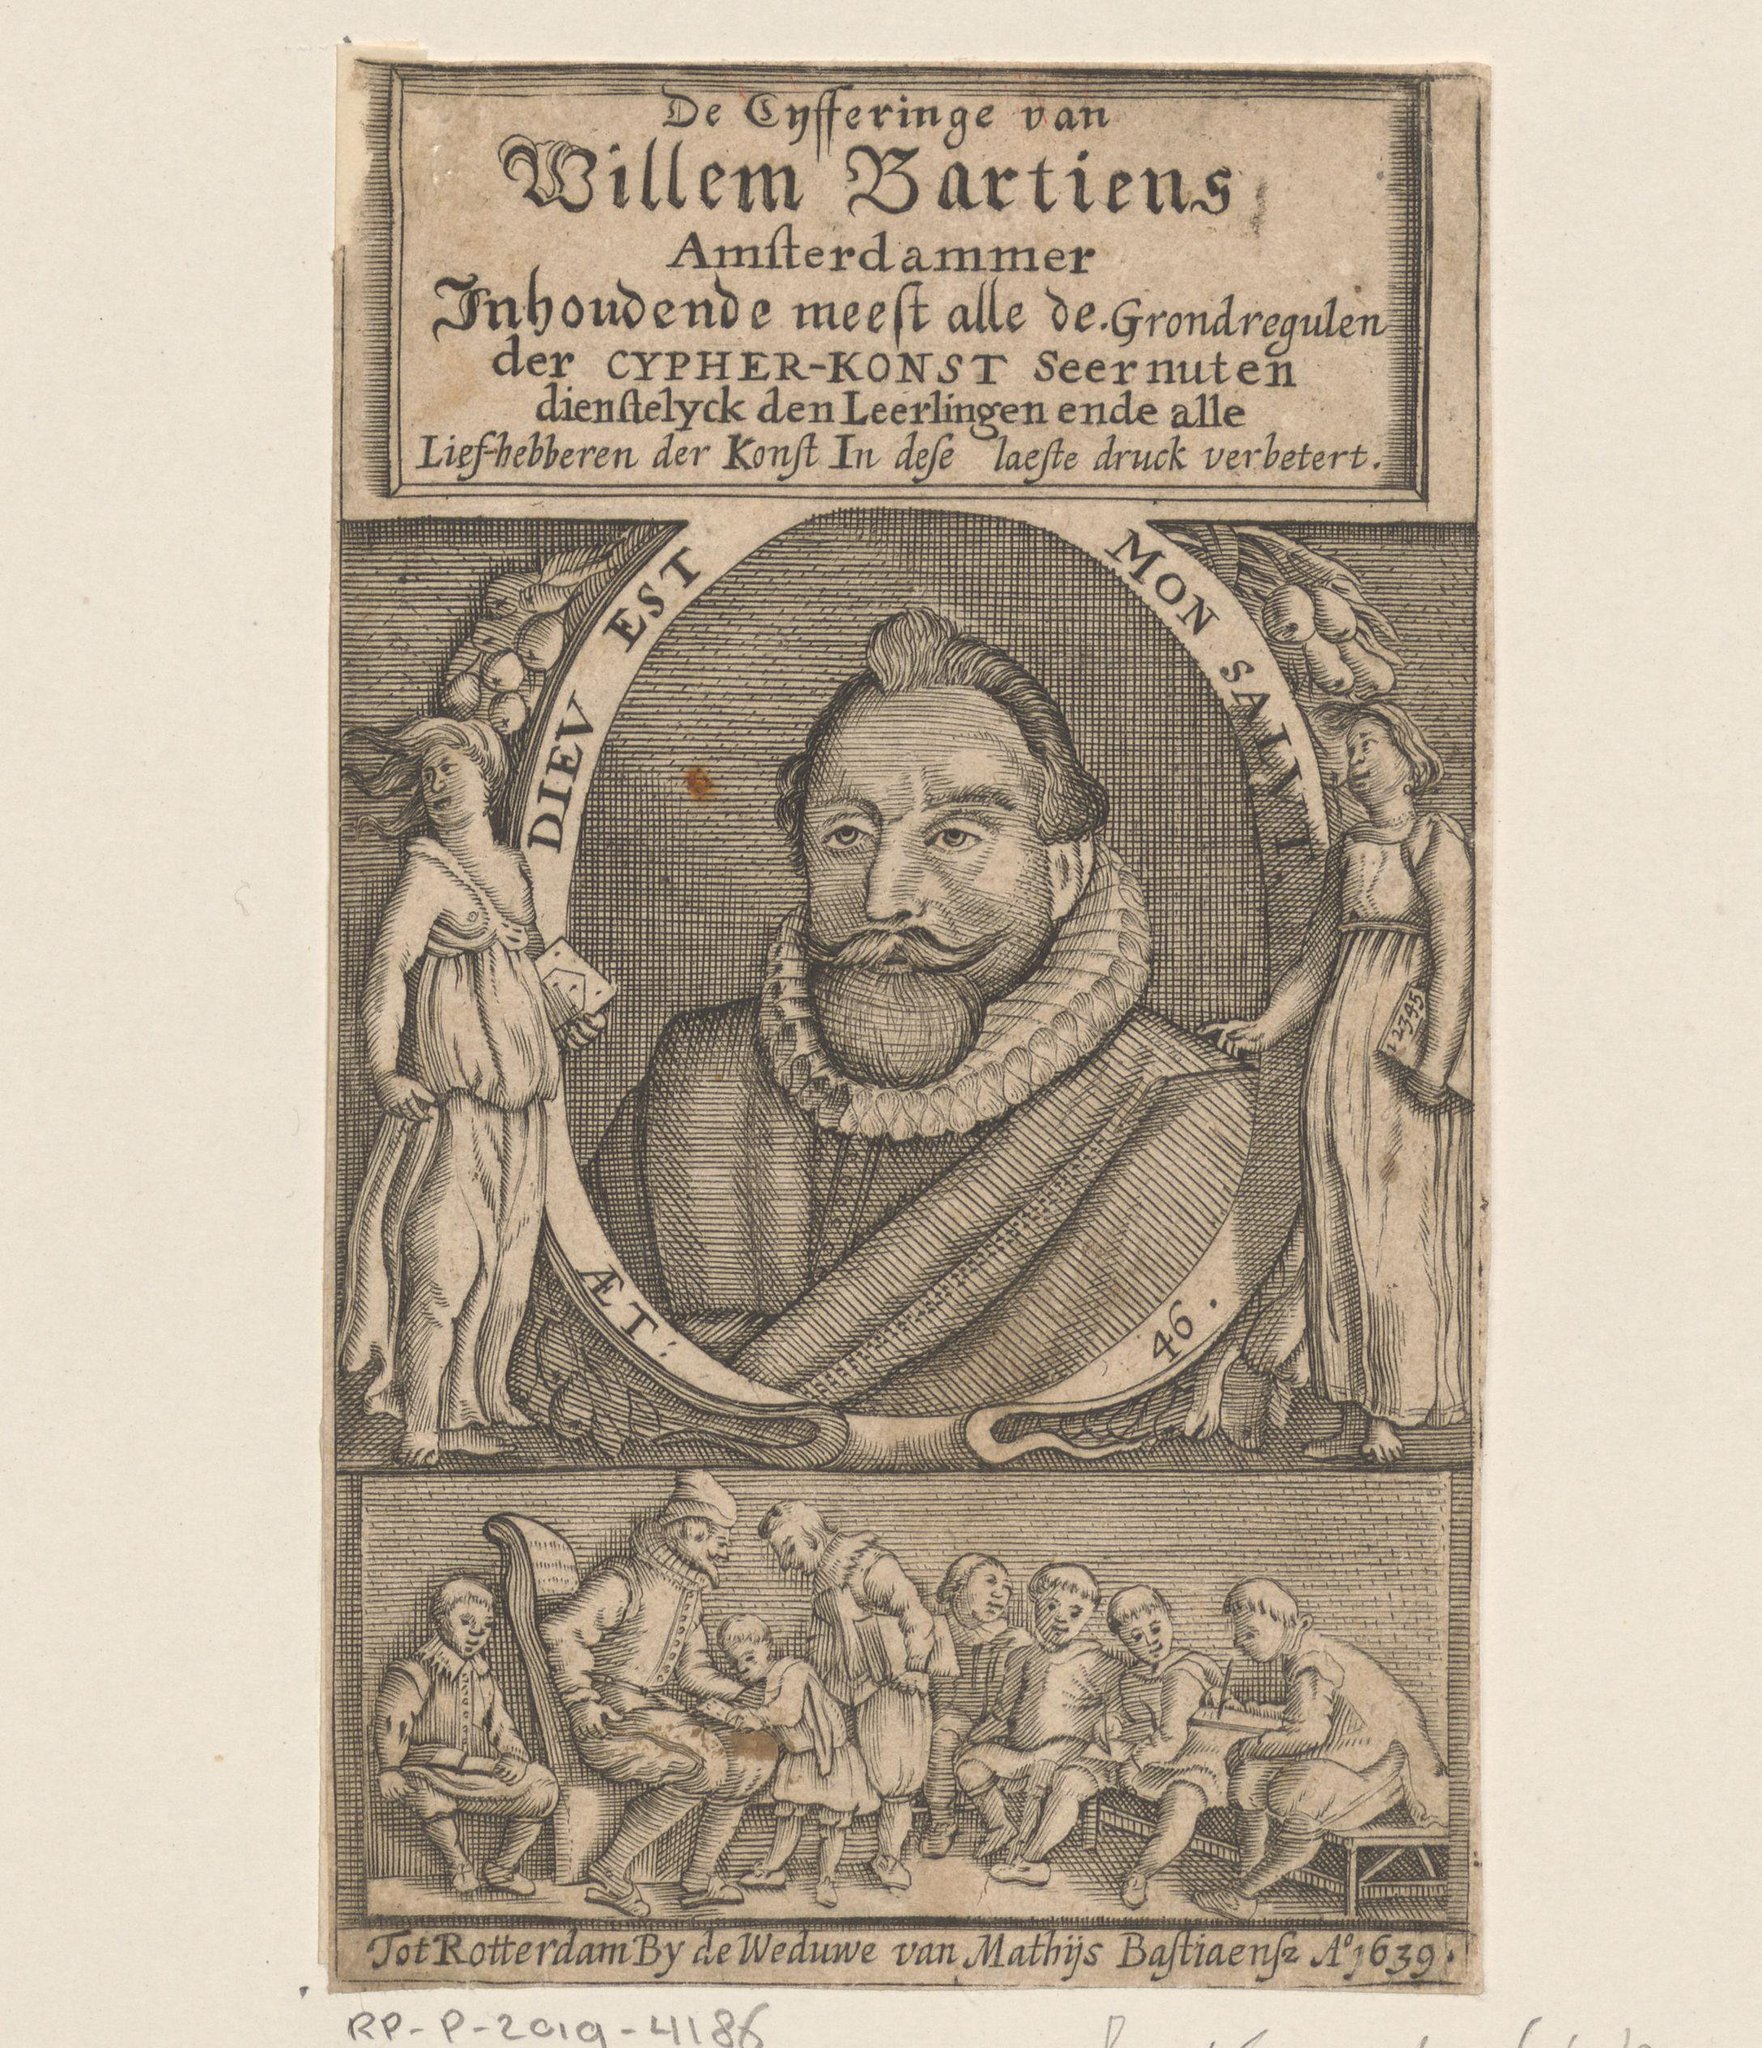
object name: titelblad, titelpagina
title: Titelpagina voor: Willem Bartjens, De cyfferinge, 1639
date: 1639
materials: paper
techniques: engraving, etching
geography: rotterdam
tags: historical persons, elementary school; class, form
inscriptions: date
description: Titelpagina voor: Bartjens, Willem. De cyfferinge. Rotterdam: weduwe Matthijs Bastiaensz, 1639.